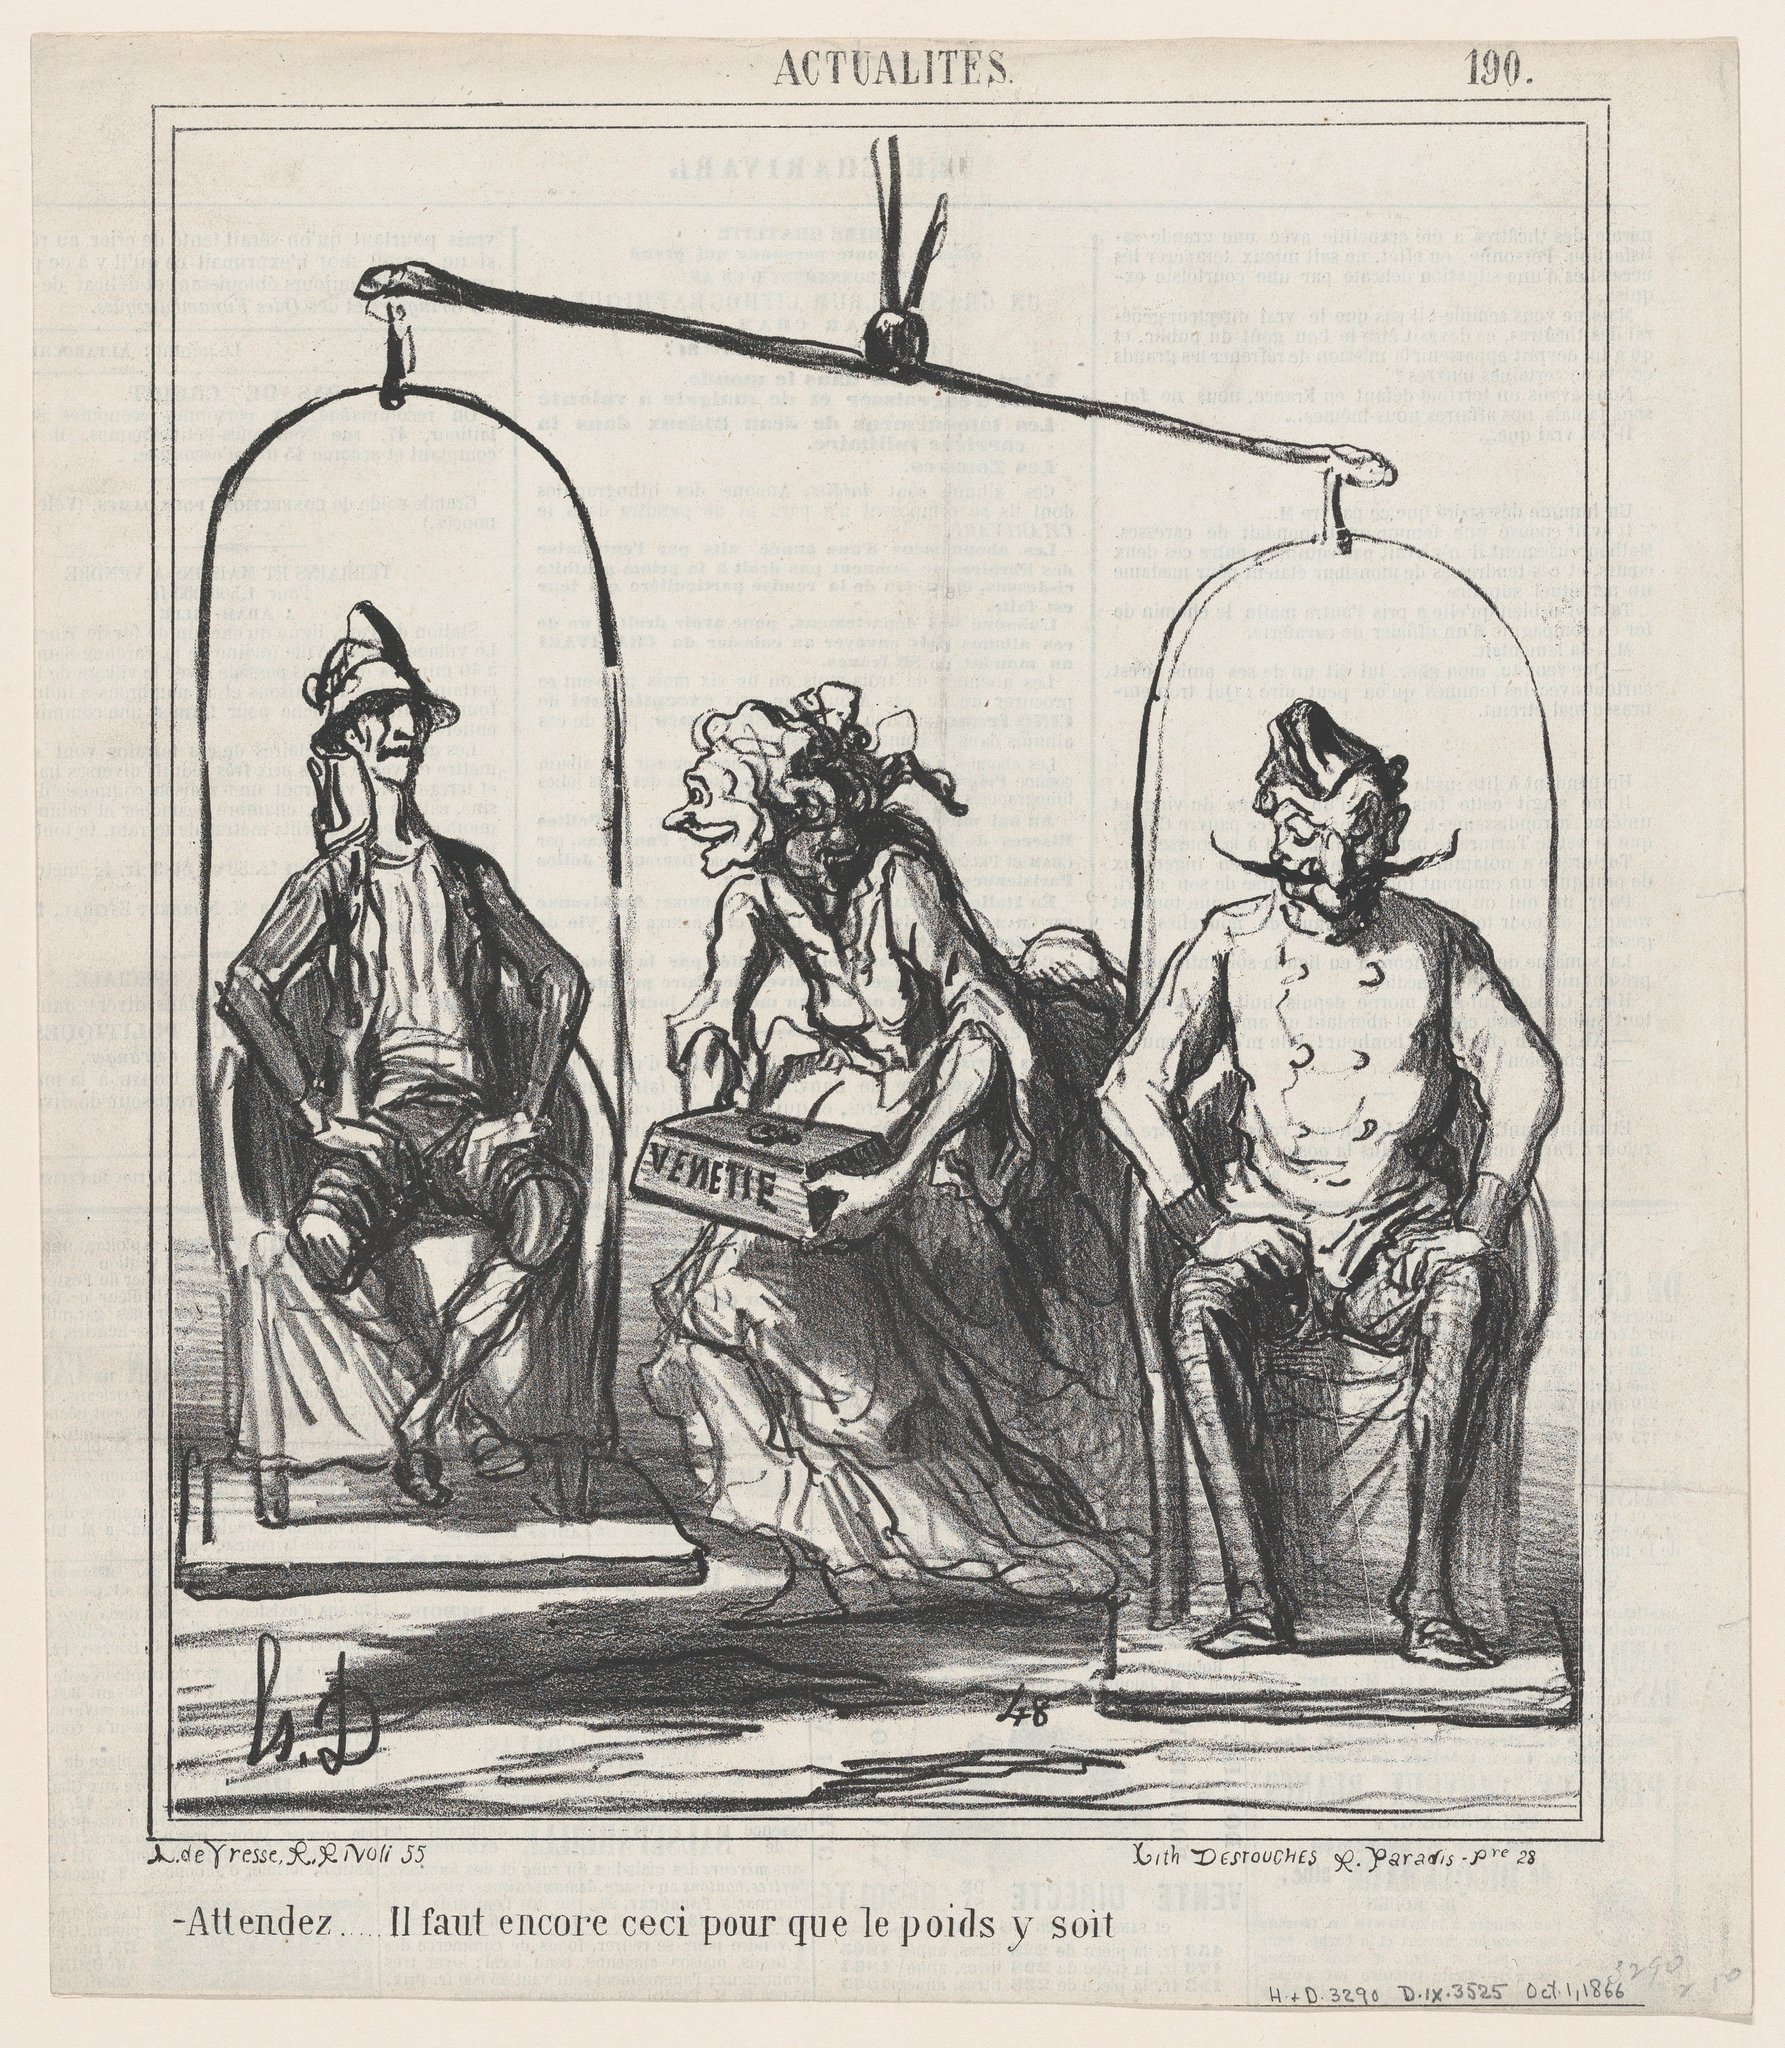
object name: print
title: Wait, we still need this to get the weight right!, from "News of the Day"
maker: honoré daumier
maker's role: artist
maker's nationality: french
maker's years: 1808-1879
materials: paper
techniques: lithograph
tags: satire,men,women